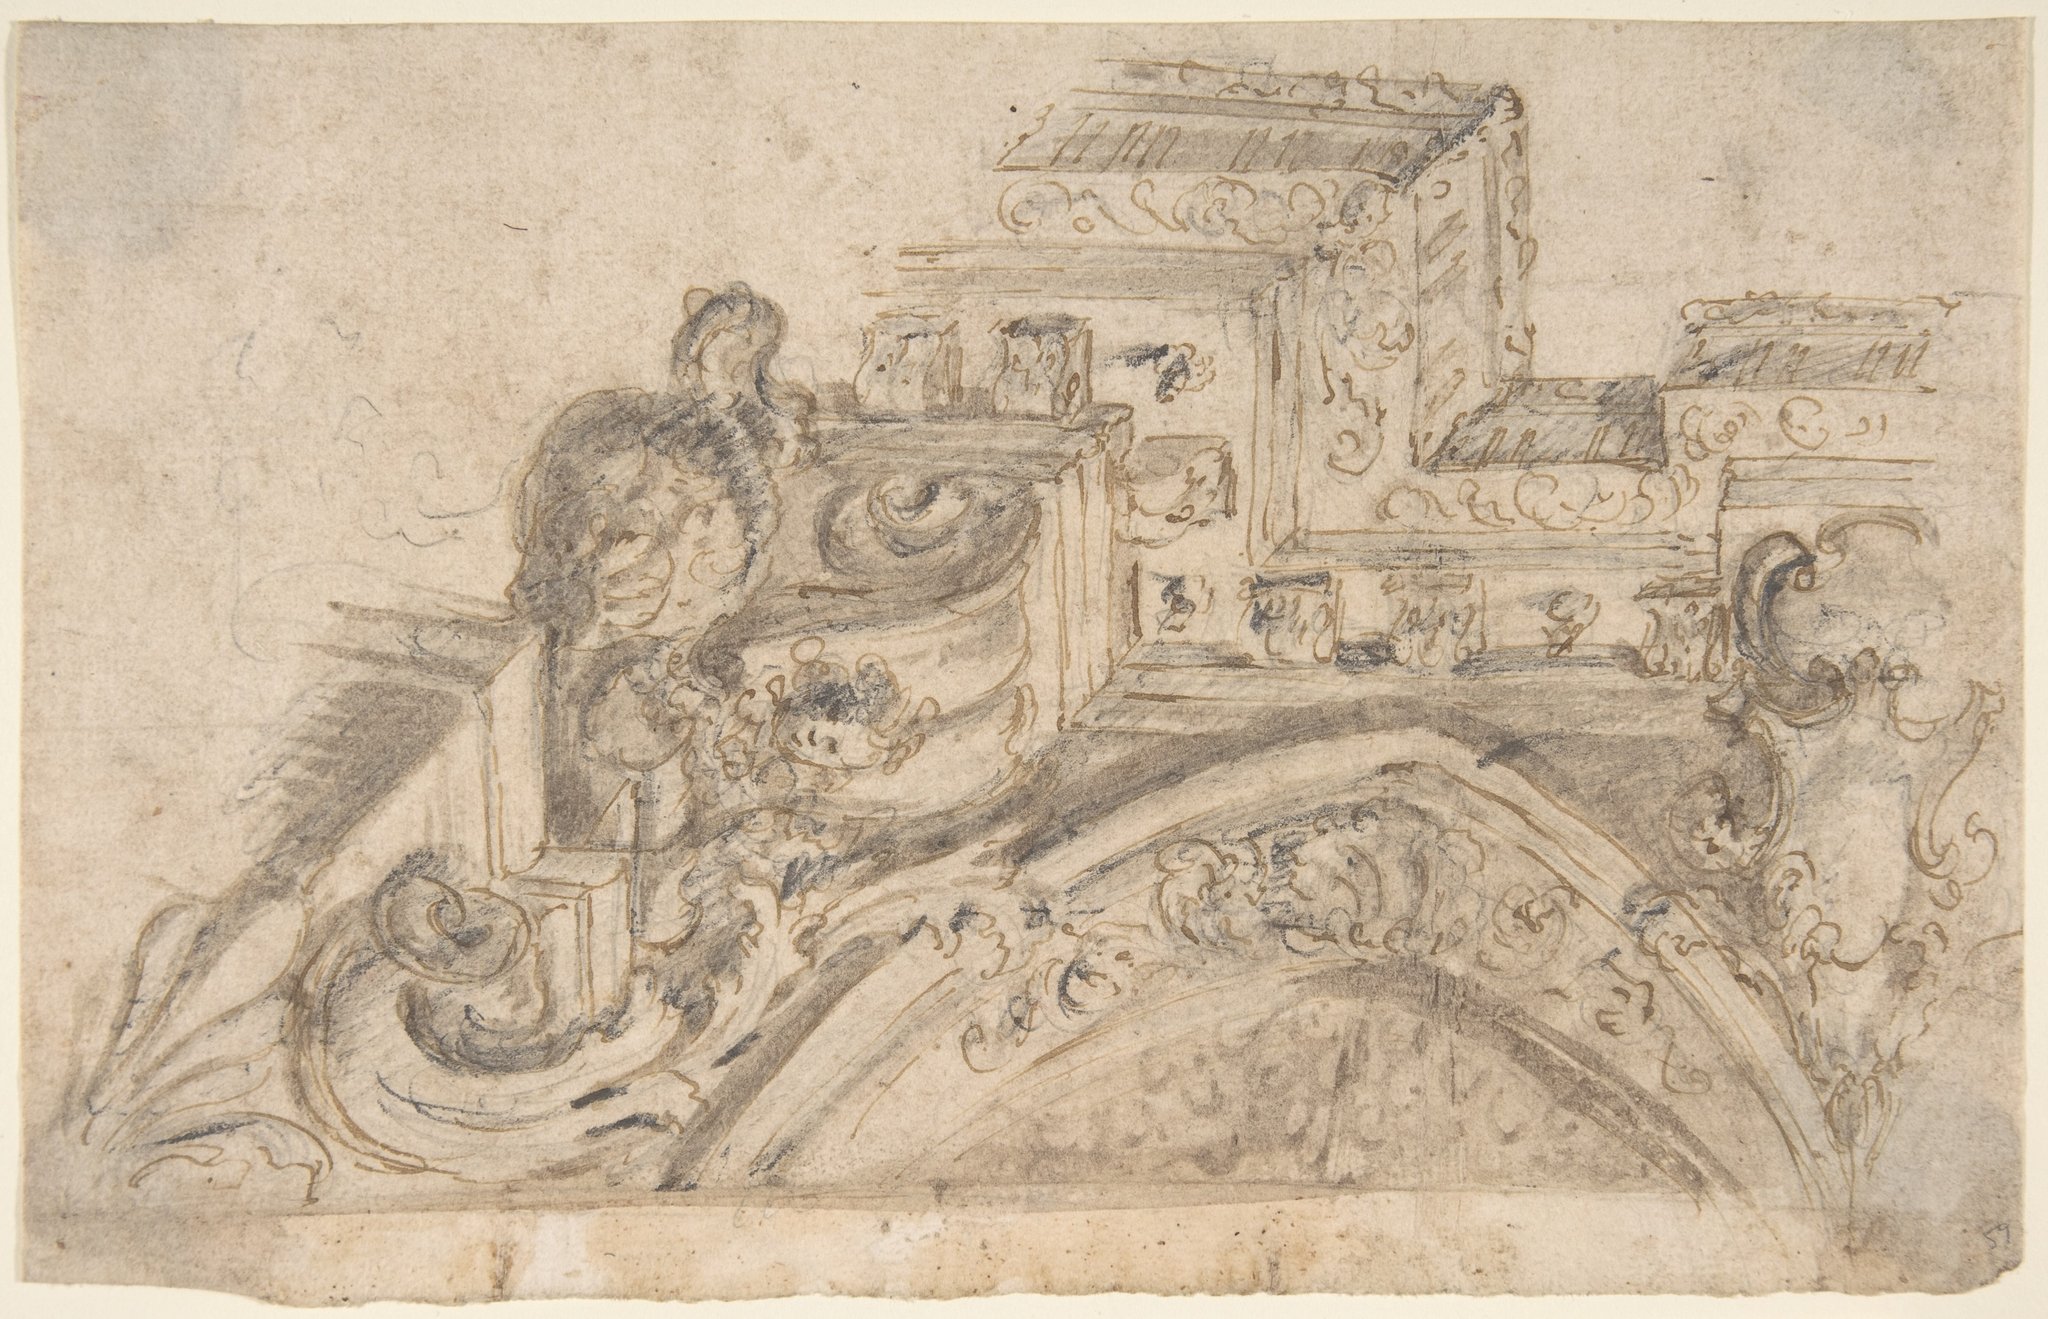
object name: drawing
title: Design for the Corner of a Painted Ceiling seen in Perspective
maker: anonymous, italian, piedmontese, 18th century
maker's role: artist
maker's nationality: italian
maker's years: 1700-1800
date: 1700-1780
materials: graphite, ink, drawing material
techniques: brush, pen, wash